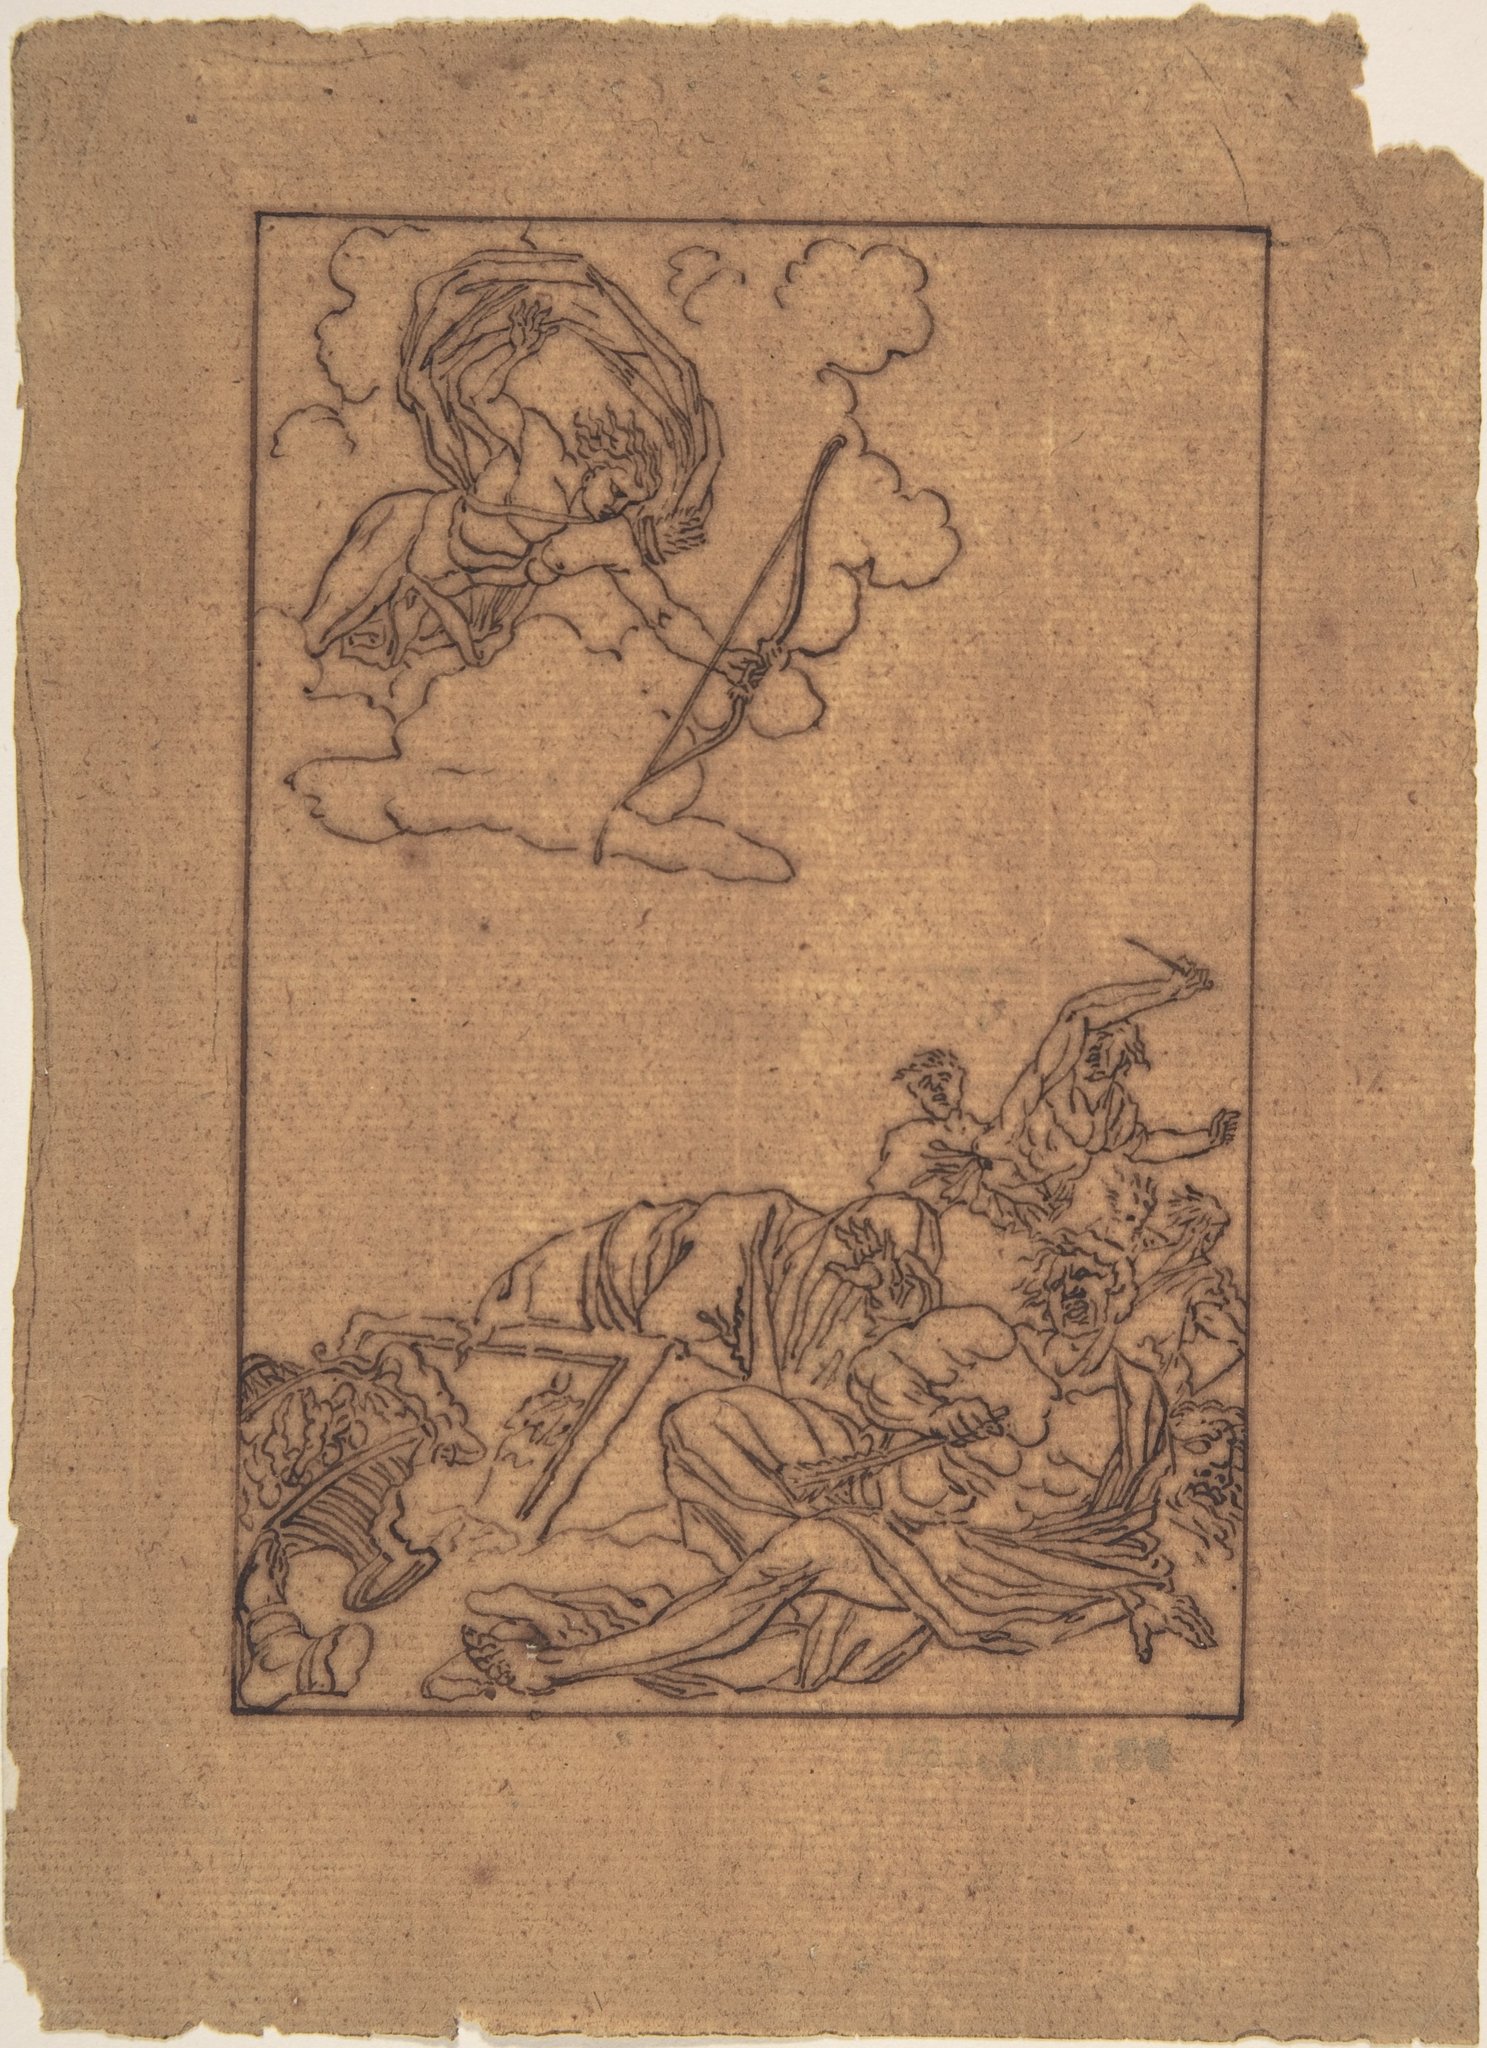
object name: drawing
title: Apollo and the Niobids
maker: anonymous, french, 18th century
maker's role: artist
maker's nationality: french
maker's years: 1700-1800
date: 1701-1800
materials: ink, paper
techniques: pen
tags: men,apollo